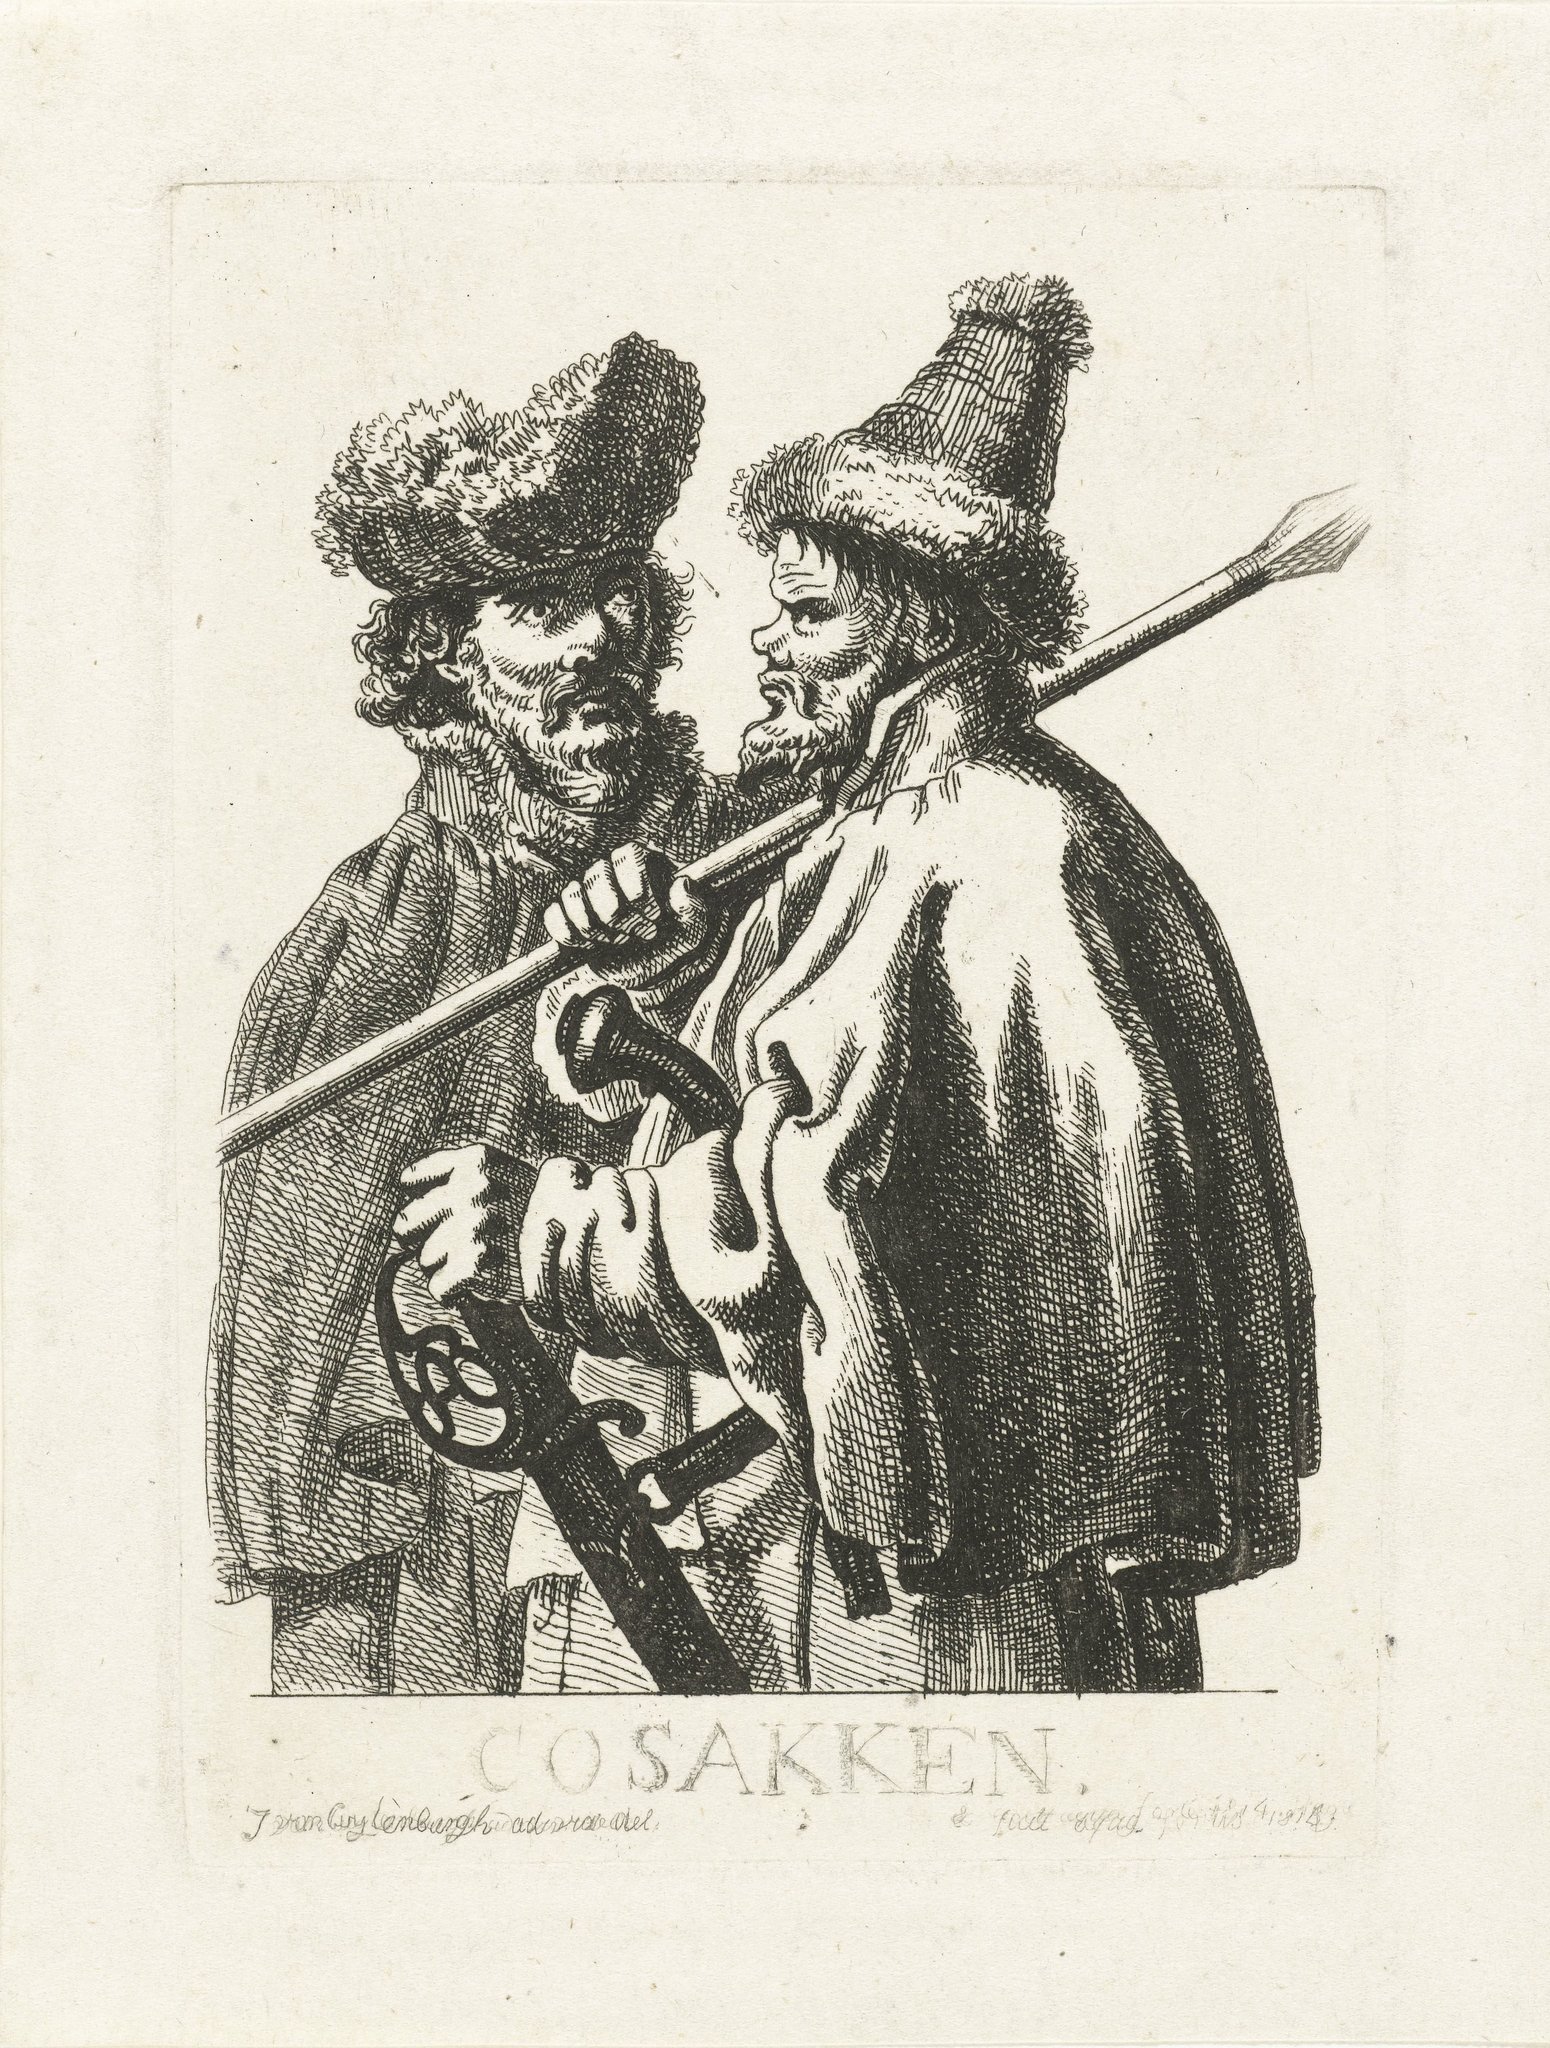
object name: print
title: Cosakken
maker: johannes van cuylenburgh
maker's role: print maker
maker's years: 1793-1841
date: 1814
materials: paper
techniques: etching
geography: netherlands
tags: private soldier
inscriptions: collector's mark: Lugt 2760, collector's mark: Lugt 2228